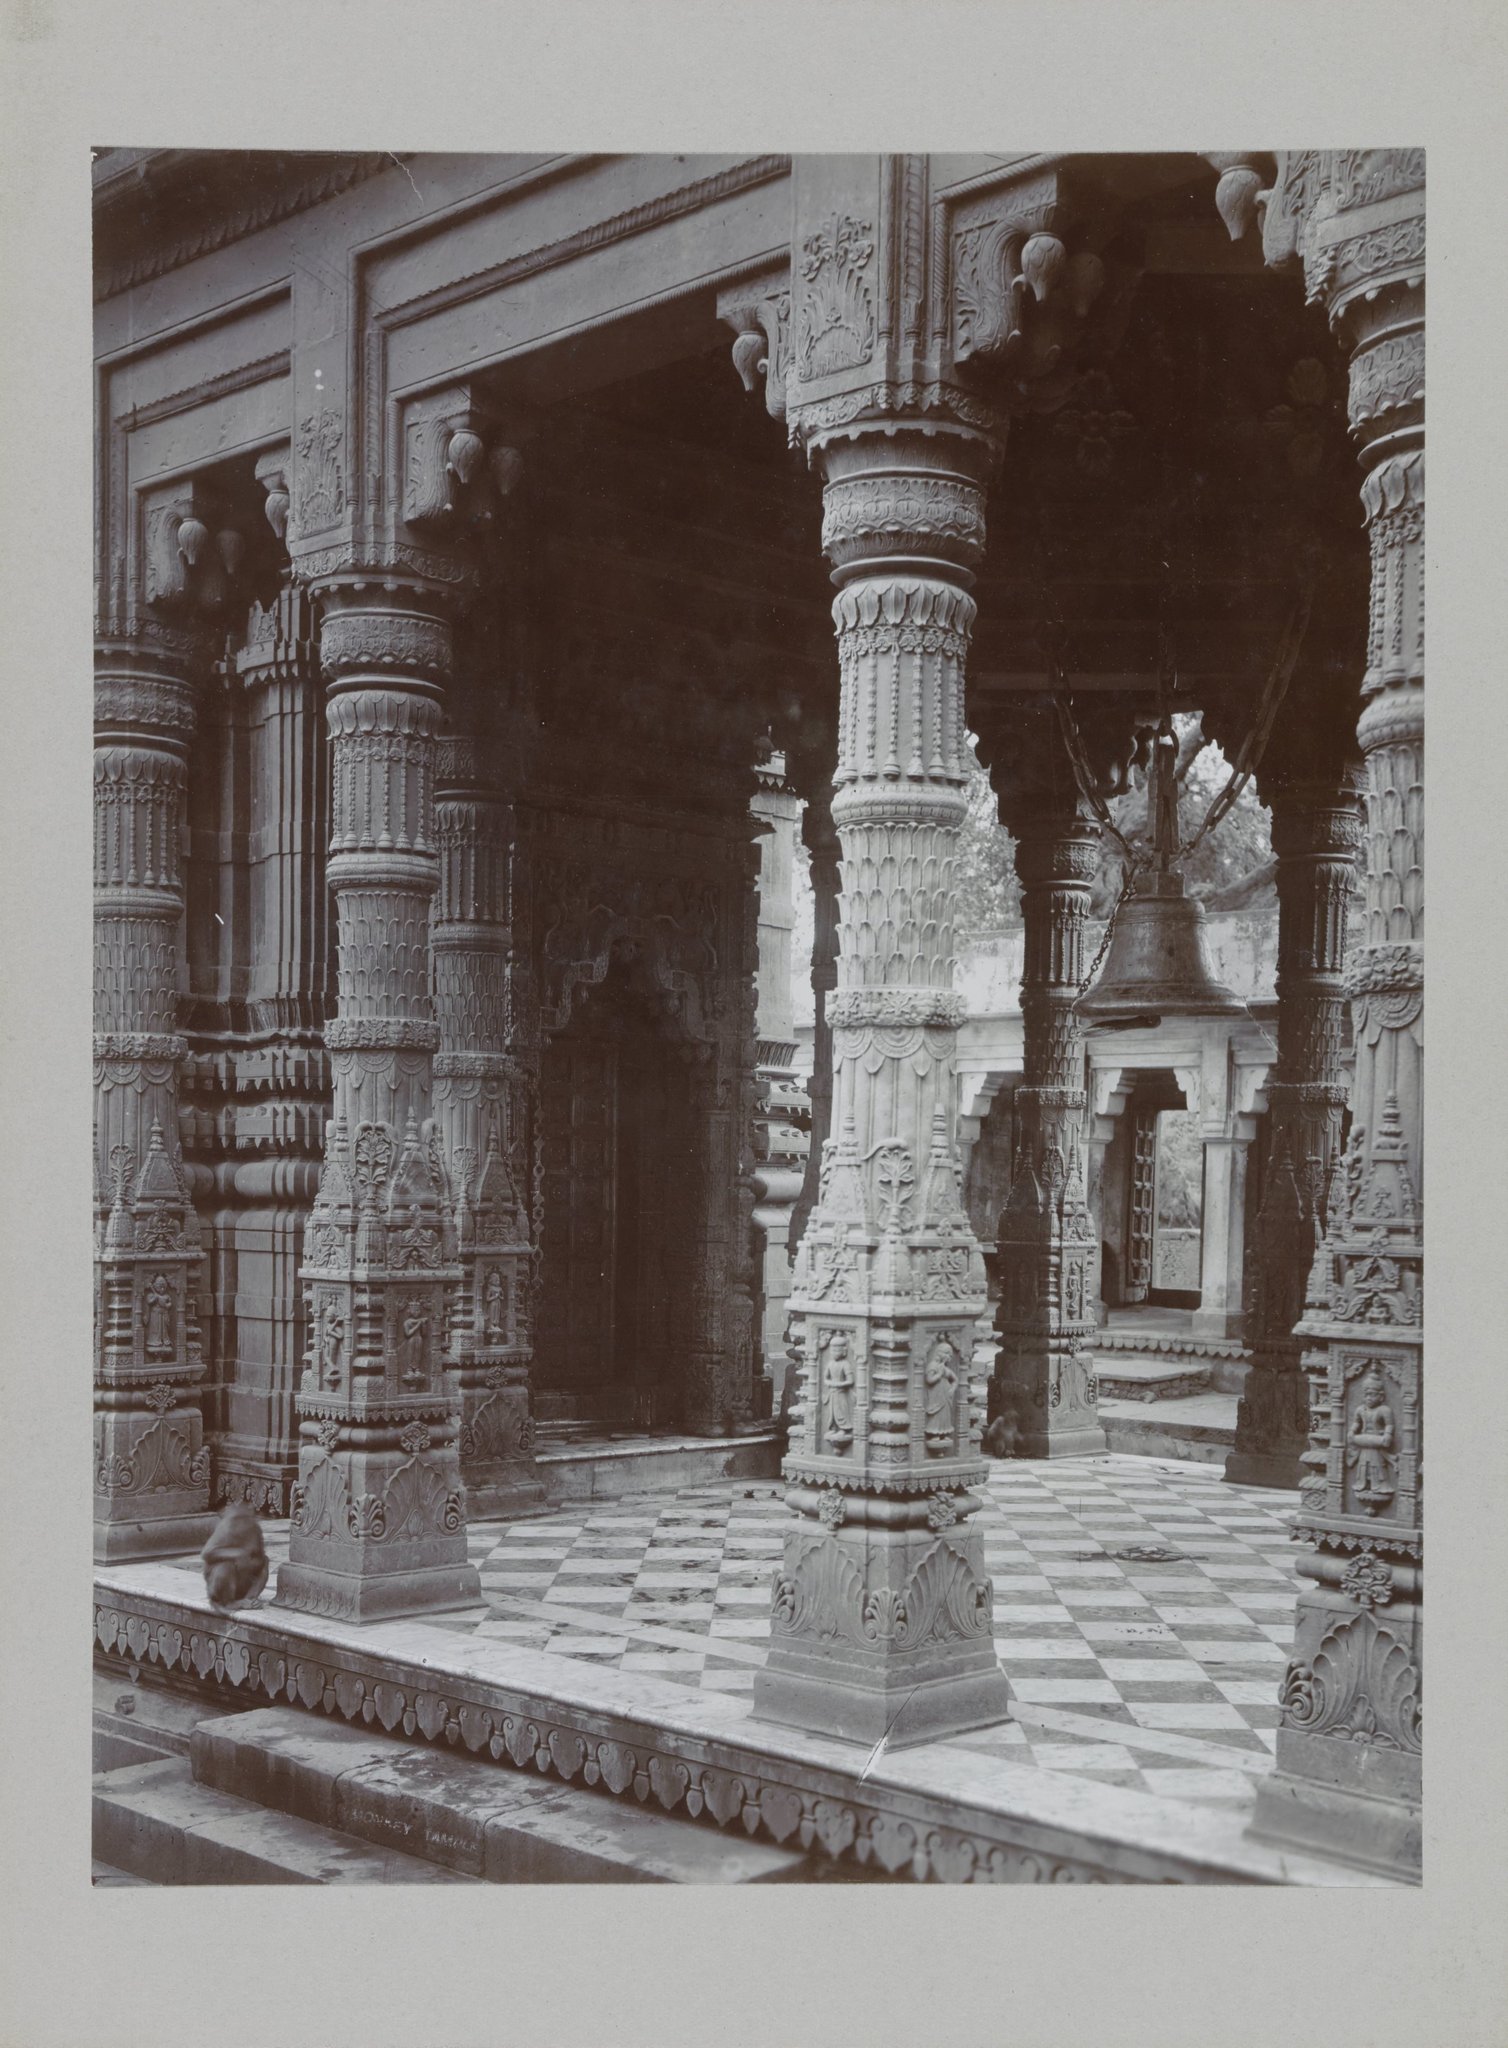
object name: photograph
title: Durga Temple (Monkey Temple), Varanasi, Uttar Pradesh, India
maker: Anonymous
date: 1895-1915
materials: cardboard, paper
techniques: gelatin silver print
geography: varanasi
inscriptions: annotation: ‘12. Benares (apentempel).’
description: Vanwege de aanwezigheid van talloze apen in het complex, staat het ook wel bekend als de apentempel.